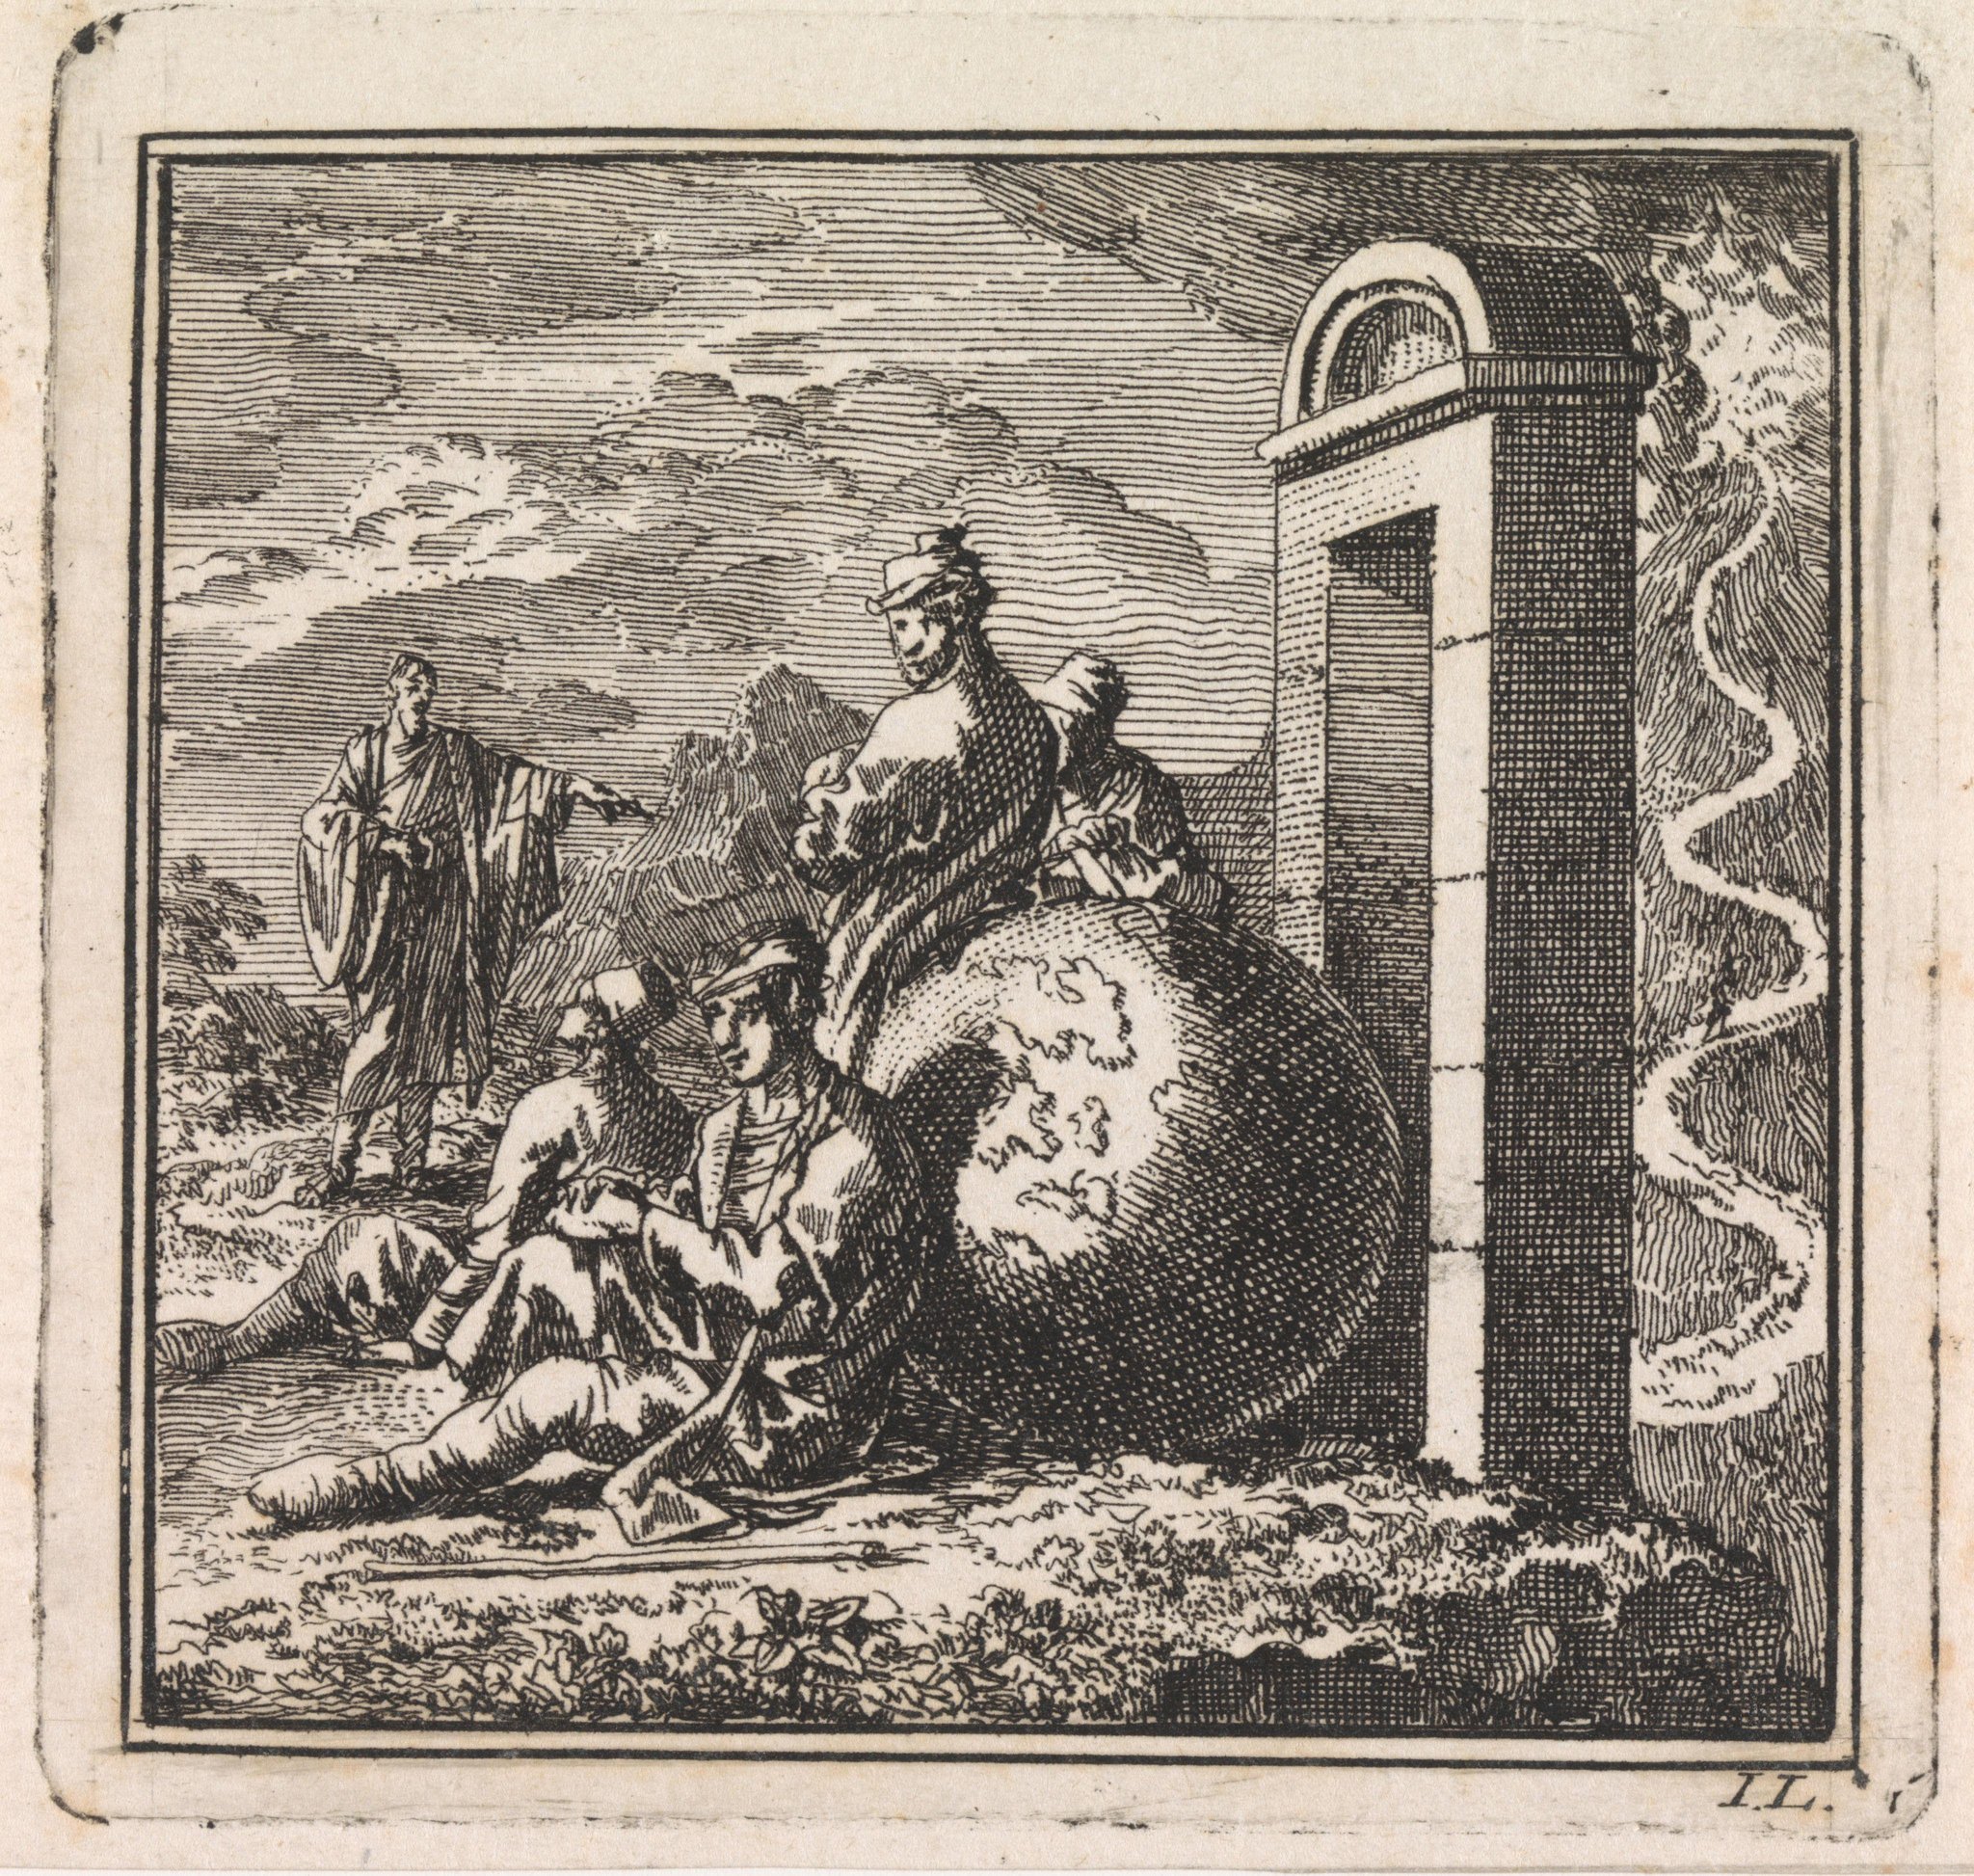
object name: print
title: Voor de smalle poort rusten enkele mannen uit bij de wereld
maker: jan luyken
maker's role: draughtsman, print maker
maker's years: 1649-1712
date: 1710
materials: paper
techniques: etching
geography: amsterdam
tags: the narrow way ~ doctrine of christ on love, etc., earth, world as celestial body, (traveller) resting in the open air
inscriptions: collector's mark: Lugt 2228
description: Illustratie uit: Luyken, Jan. De onwaardige wereld, vertoond in vyftig zinnebeelden, met godlyke spreuken en stichtelyke verzen. Amsterdam: Pieter Arentsz. II (wed.) en Cornelis van der Sys, 1710, p. 136.